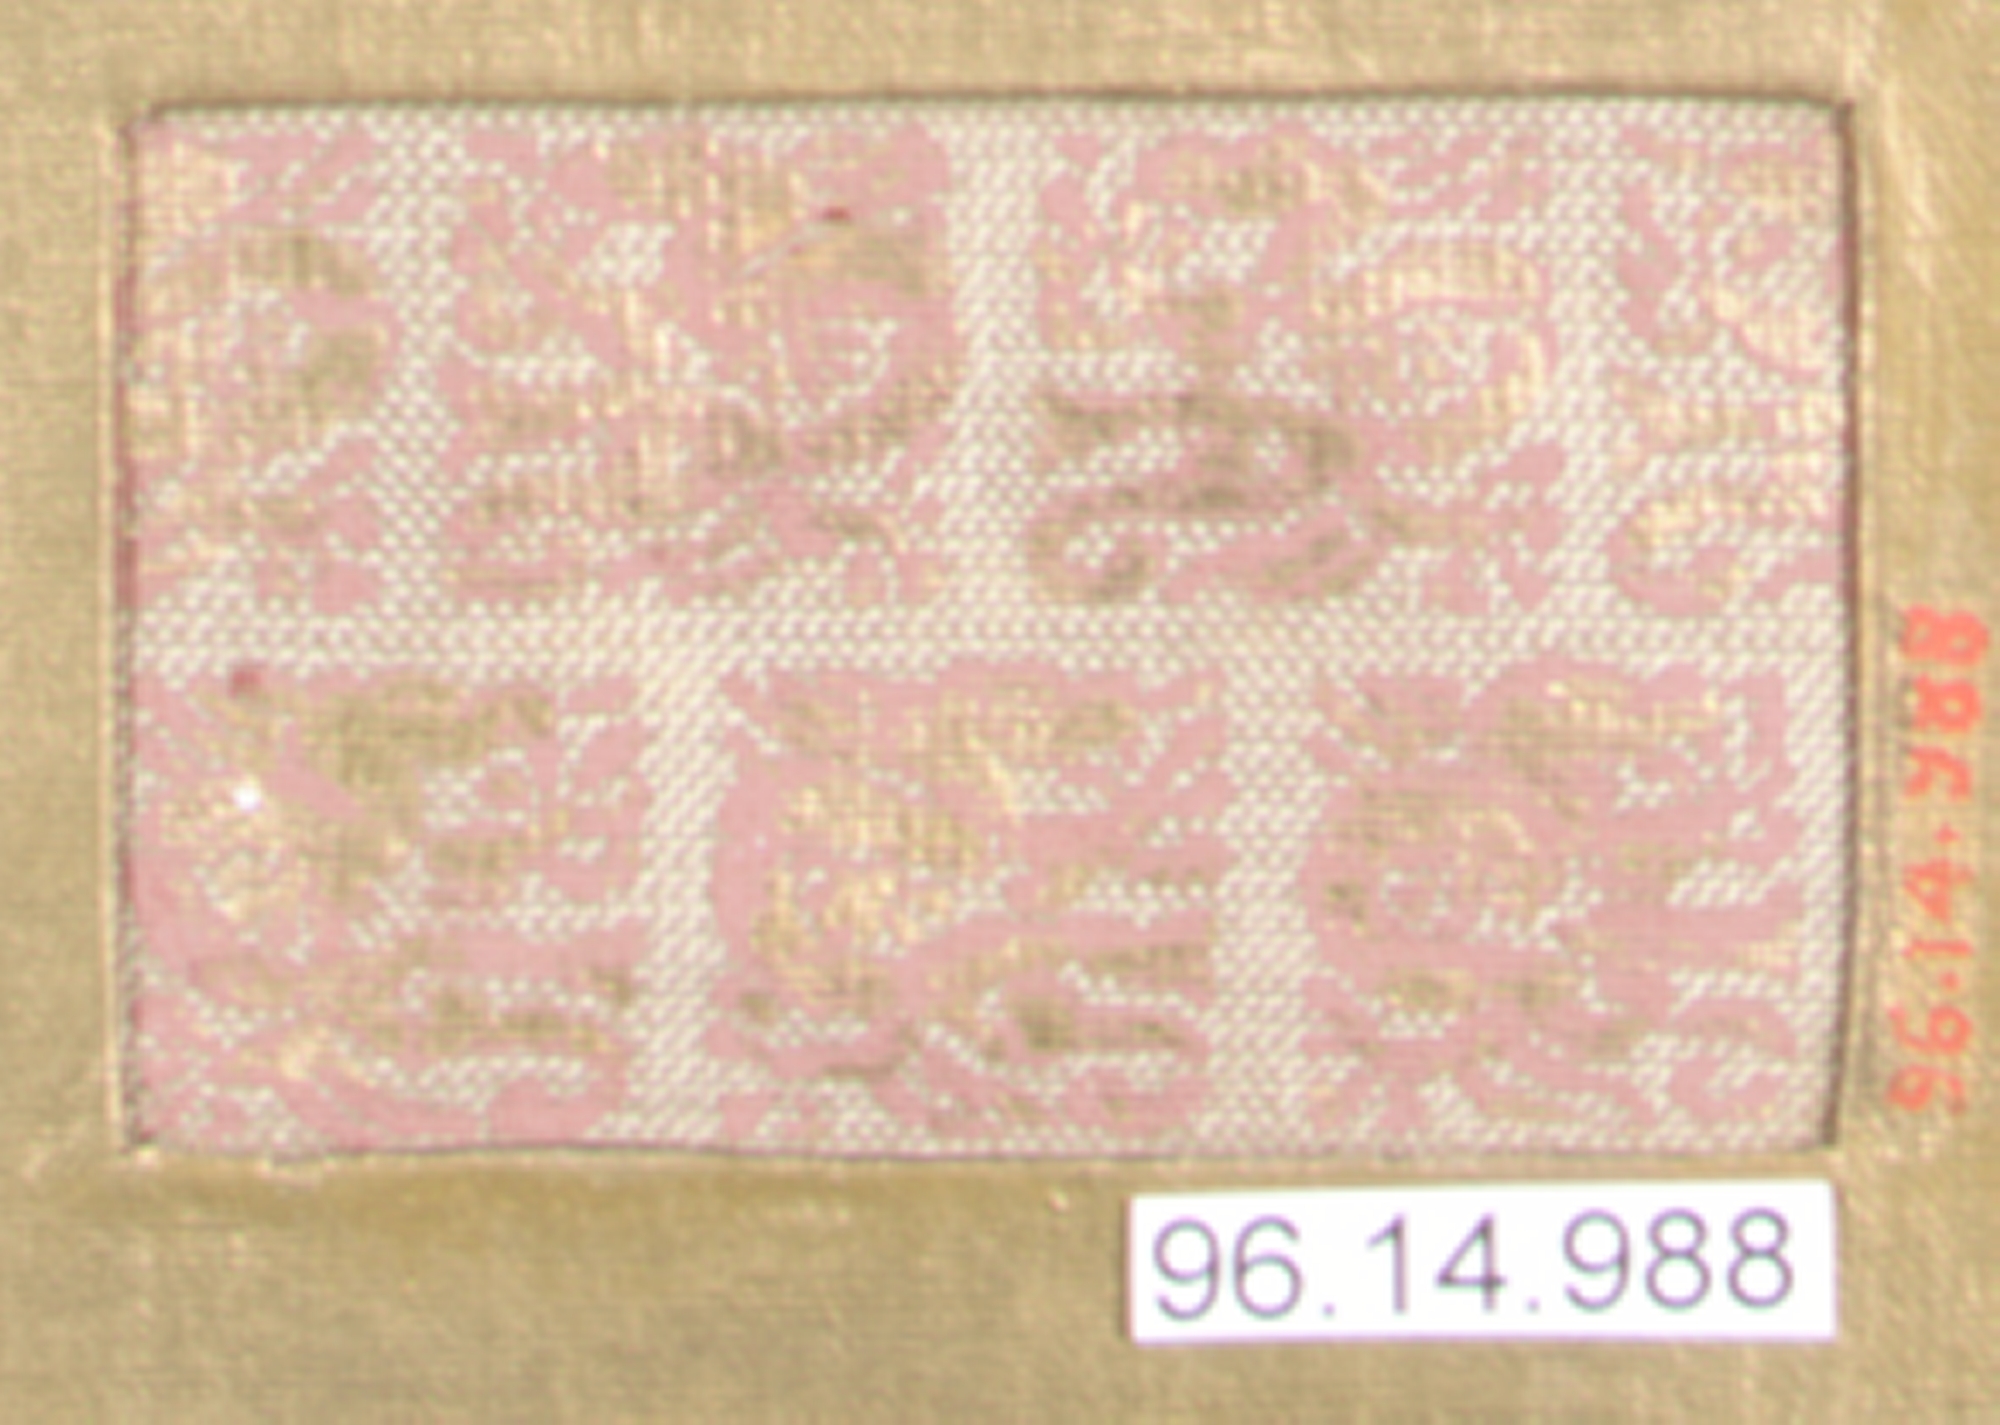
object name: piece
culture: japanese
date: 1701-1900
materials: silk